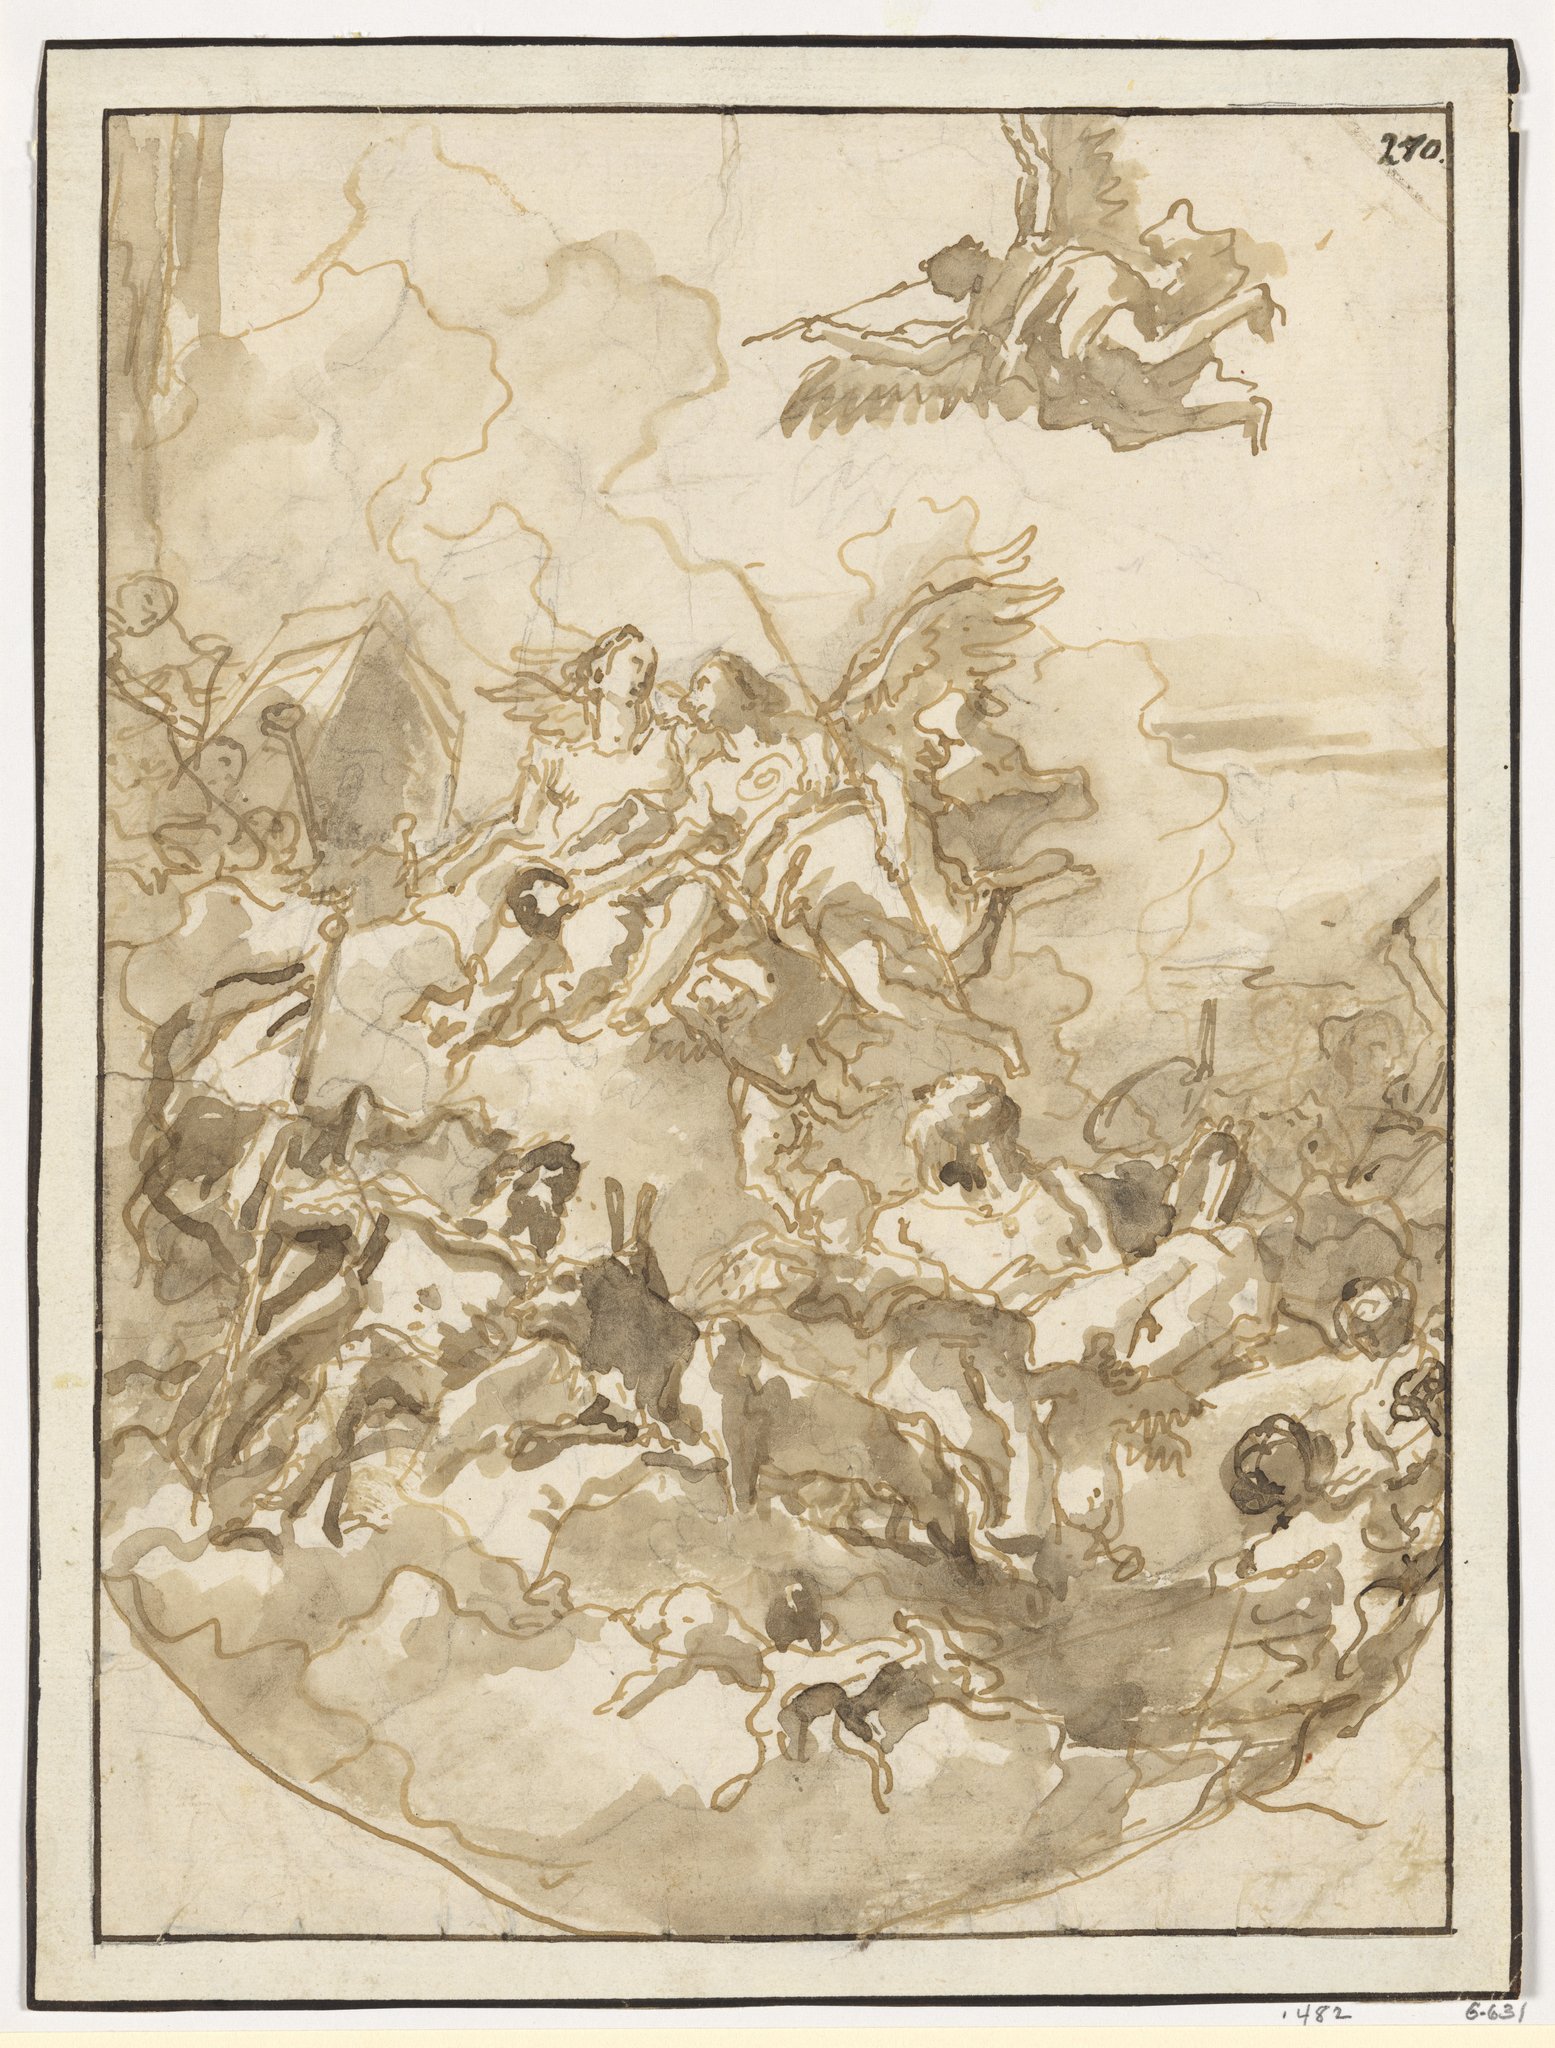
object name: drawing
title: Sketch for a Ceiling with an Allegory of Fortitude and Wisdom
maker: giovanni domenico tiepolo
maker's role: artist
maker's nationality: italian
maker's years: 1727-1804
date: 1780-1785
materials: chalk, ink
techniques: pen, wash